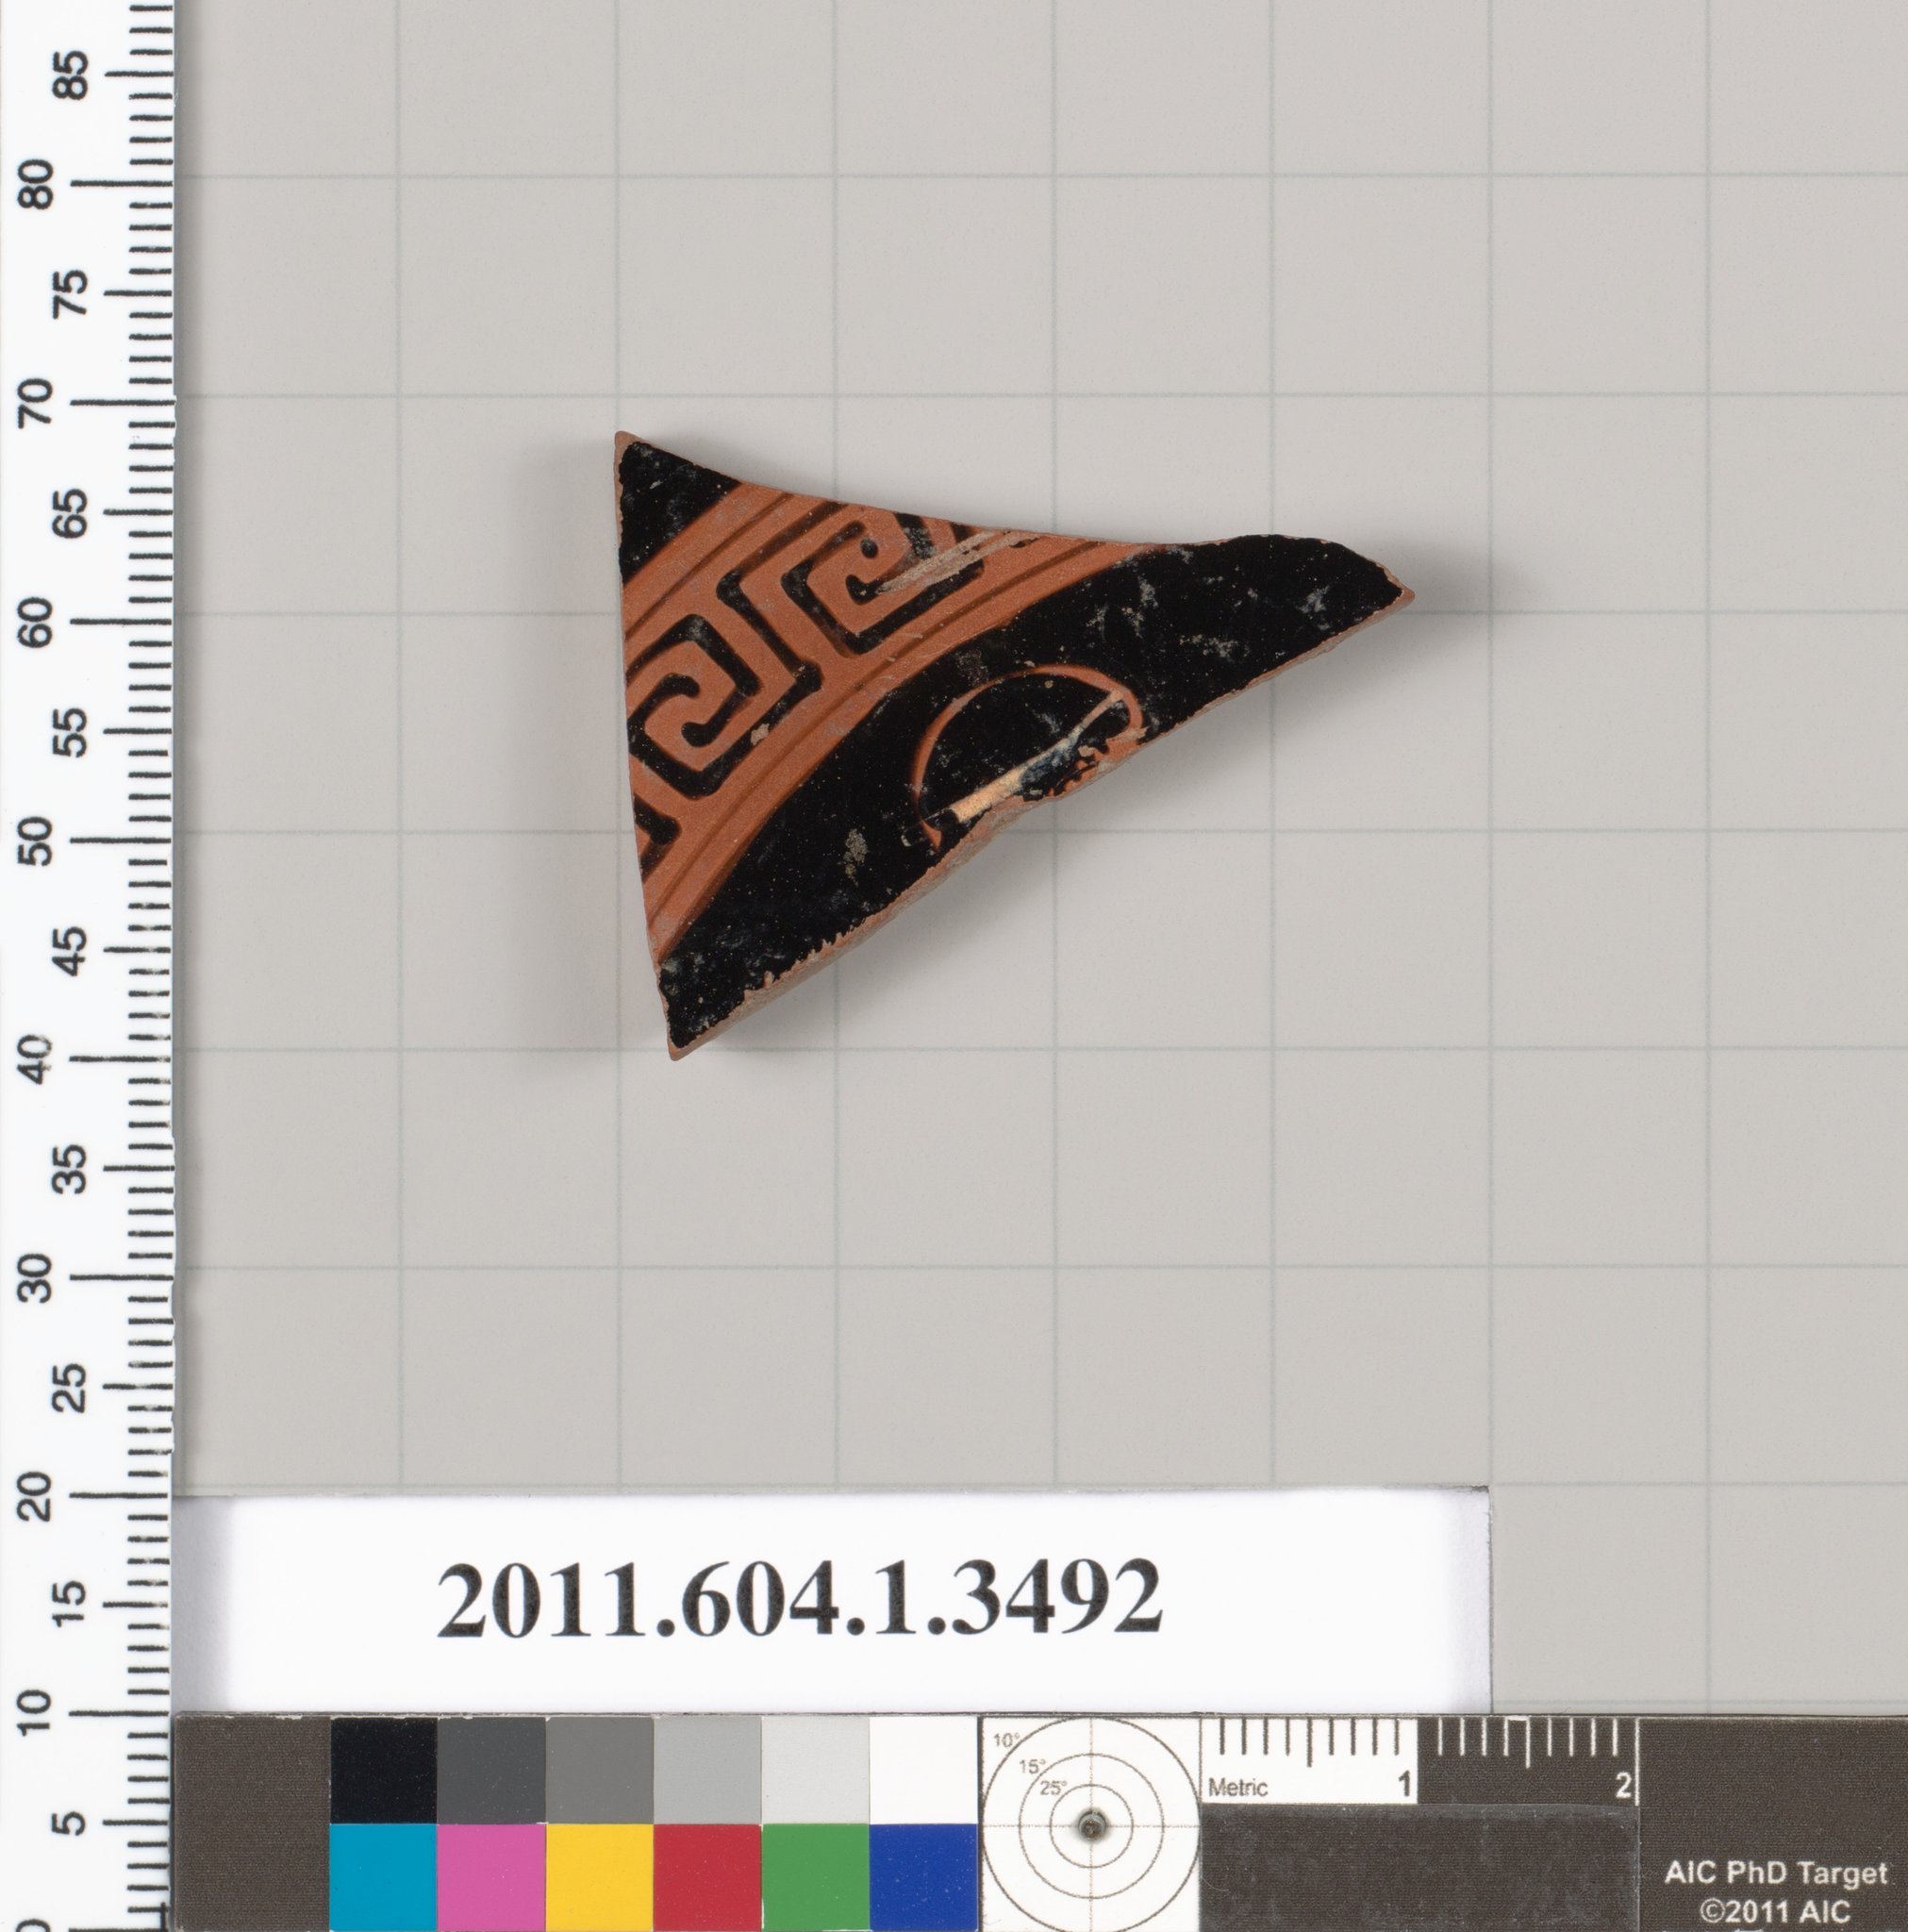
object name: kylix fragment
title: Terracotta fragment of a kylix (drinking cup)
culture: greek, attic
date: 467-435 BCE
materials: terracotta